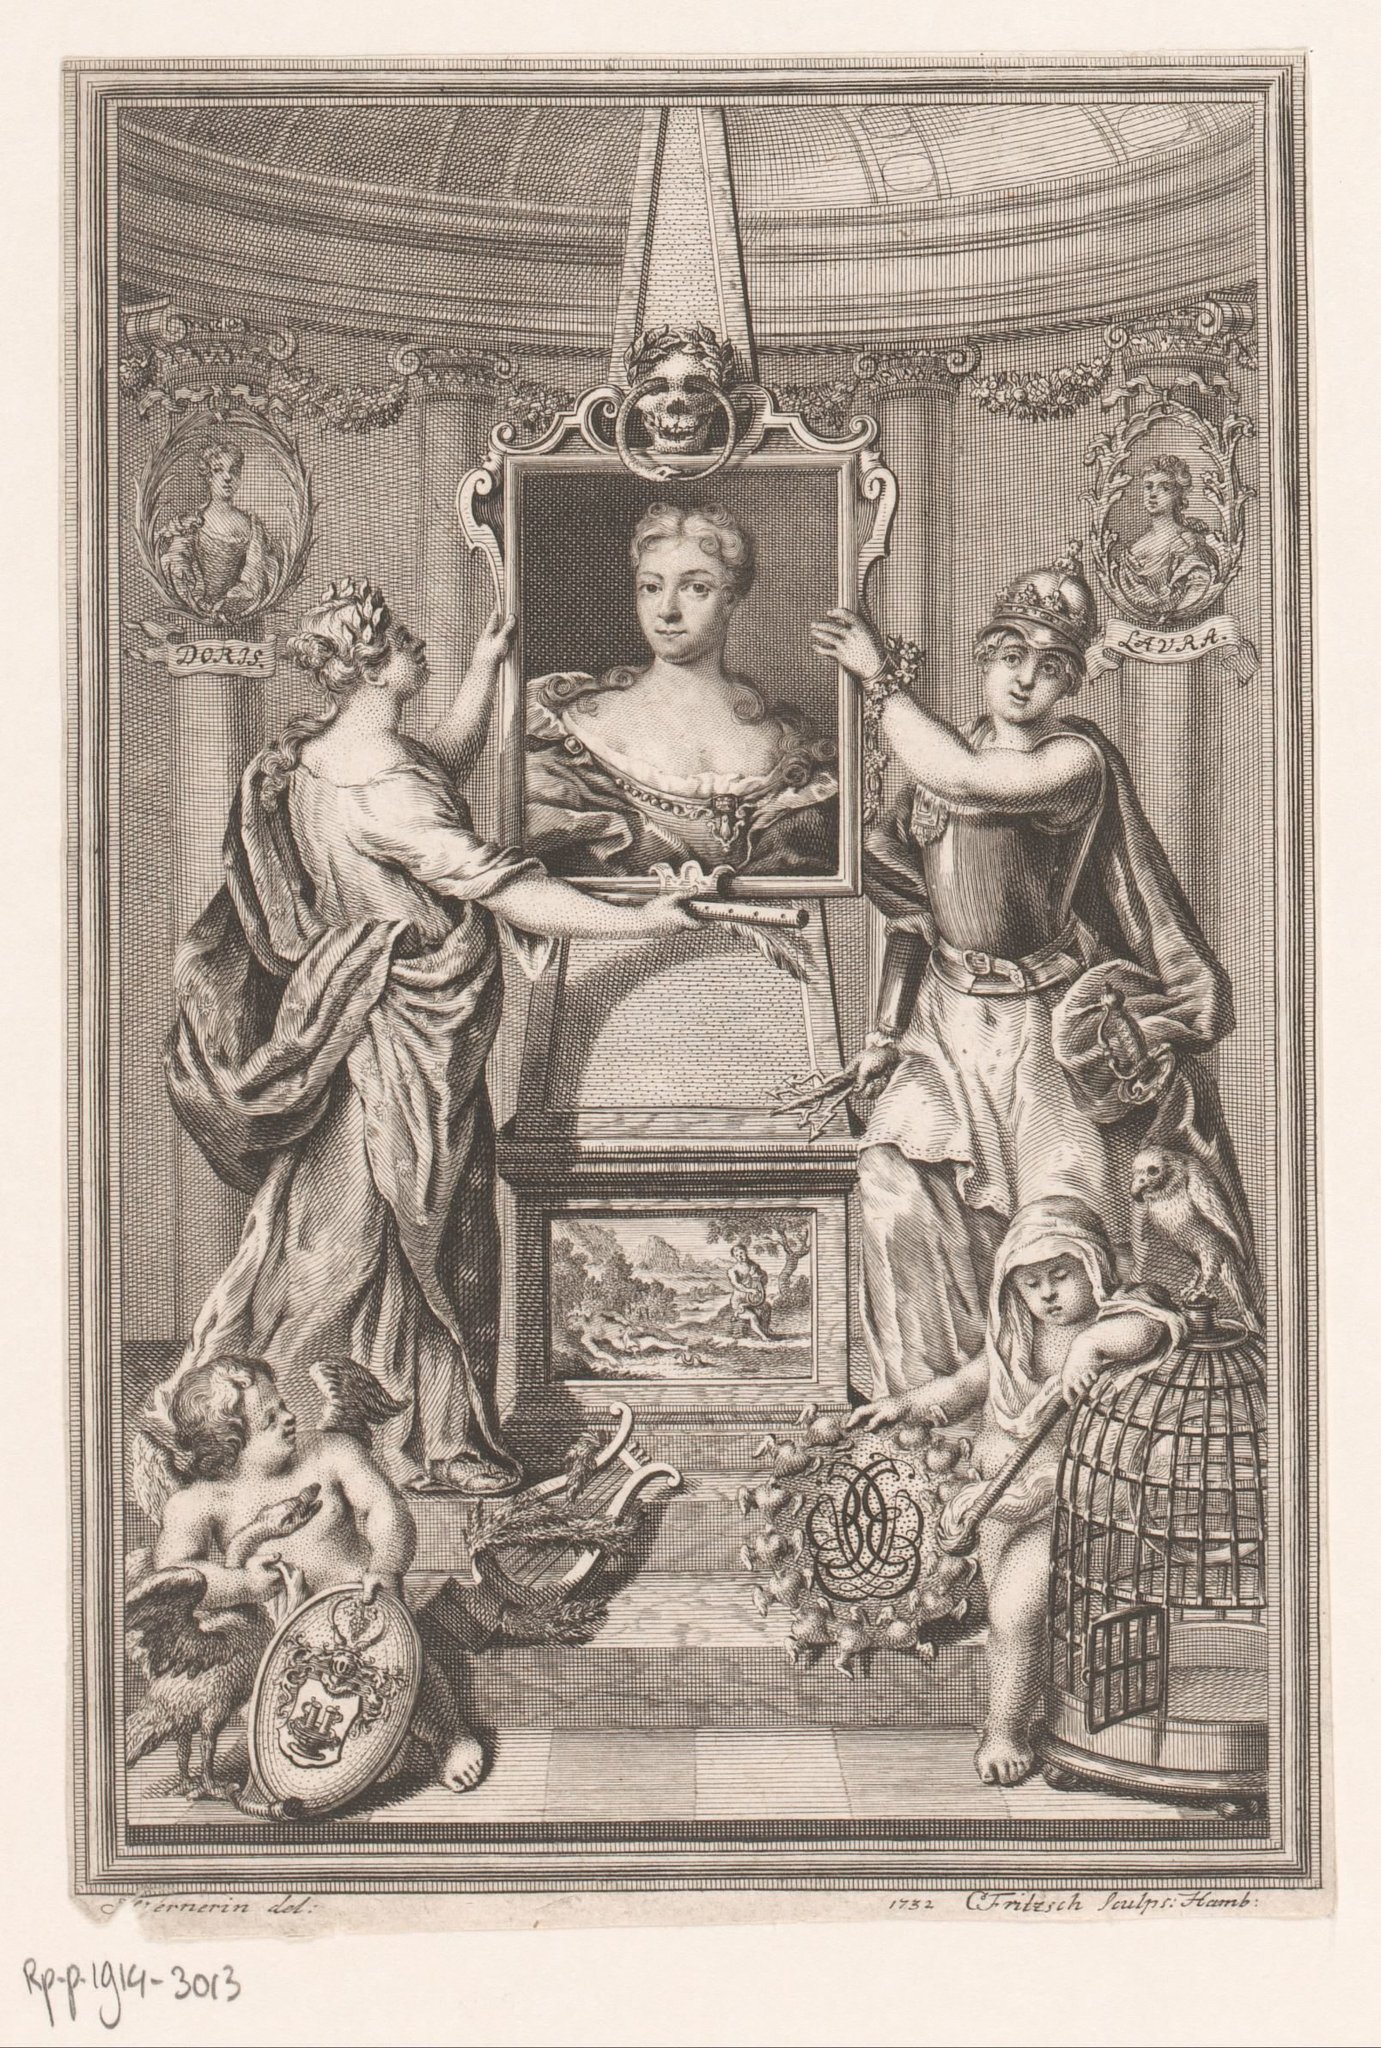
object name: print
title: Portret van Catharina Elisabeth Besser vastgehouden door Erato en Minerva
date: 1732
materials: paper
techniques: engraving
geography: hamburg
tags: berlin, torch - bb - torch held upside down, minerva as patroness, empty bird cage, historical persons - bb - woman, serpent ouroboros, grave-building, monumental tomb, erato (one of the muses); 'erato' (ripa), armorial bearing, heraldry, eurydice, while fleeing from aristaeus, is killed by a snake, death's head, skull (symbol of death)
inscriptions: collector's mark: Lugt 2228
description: Prent gebruikt voor: [Besser, Johann von]. Des Herrn von Besser Schrifften, Beydes in gebundener und ungebundener Rede. Leipzig: Johann Gottlieb Gleditsch, 1732, dl. 2.